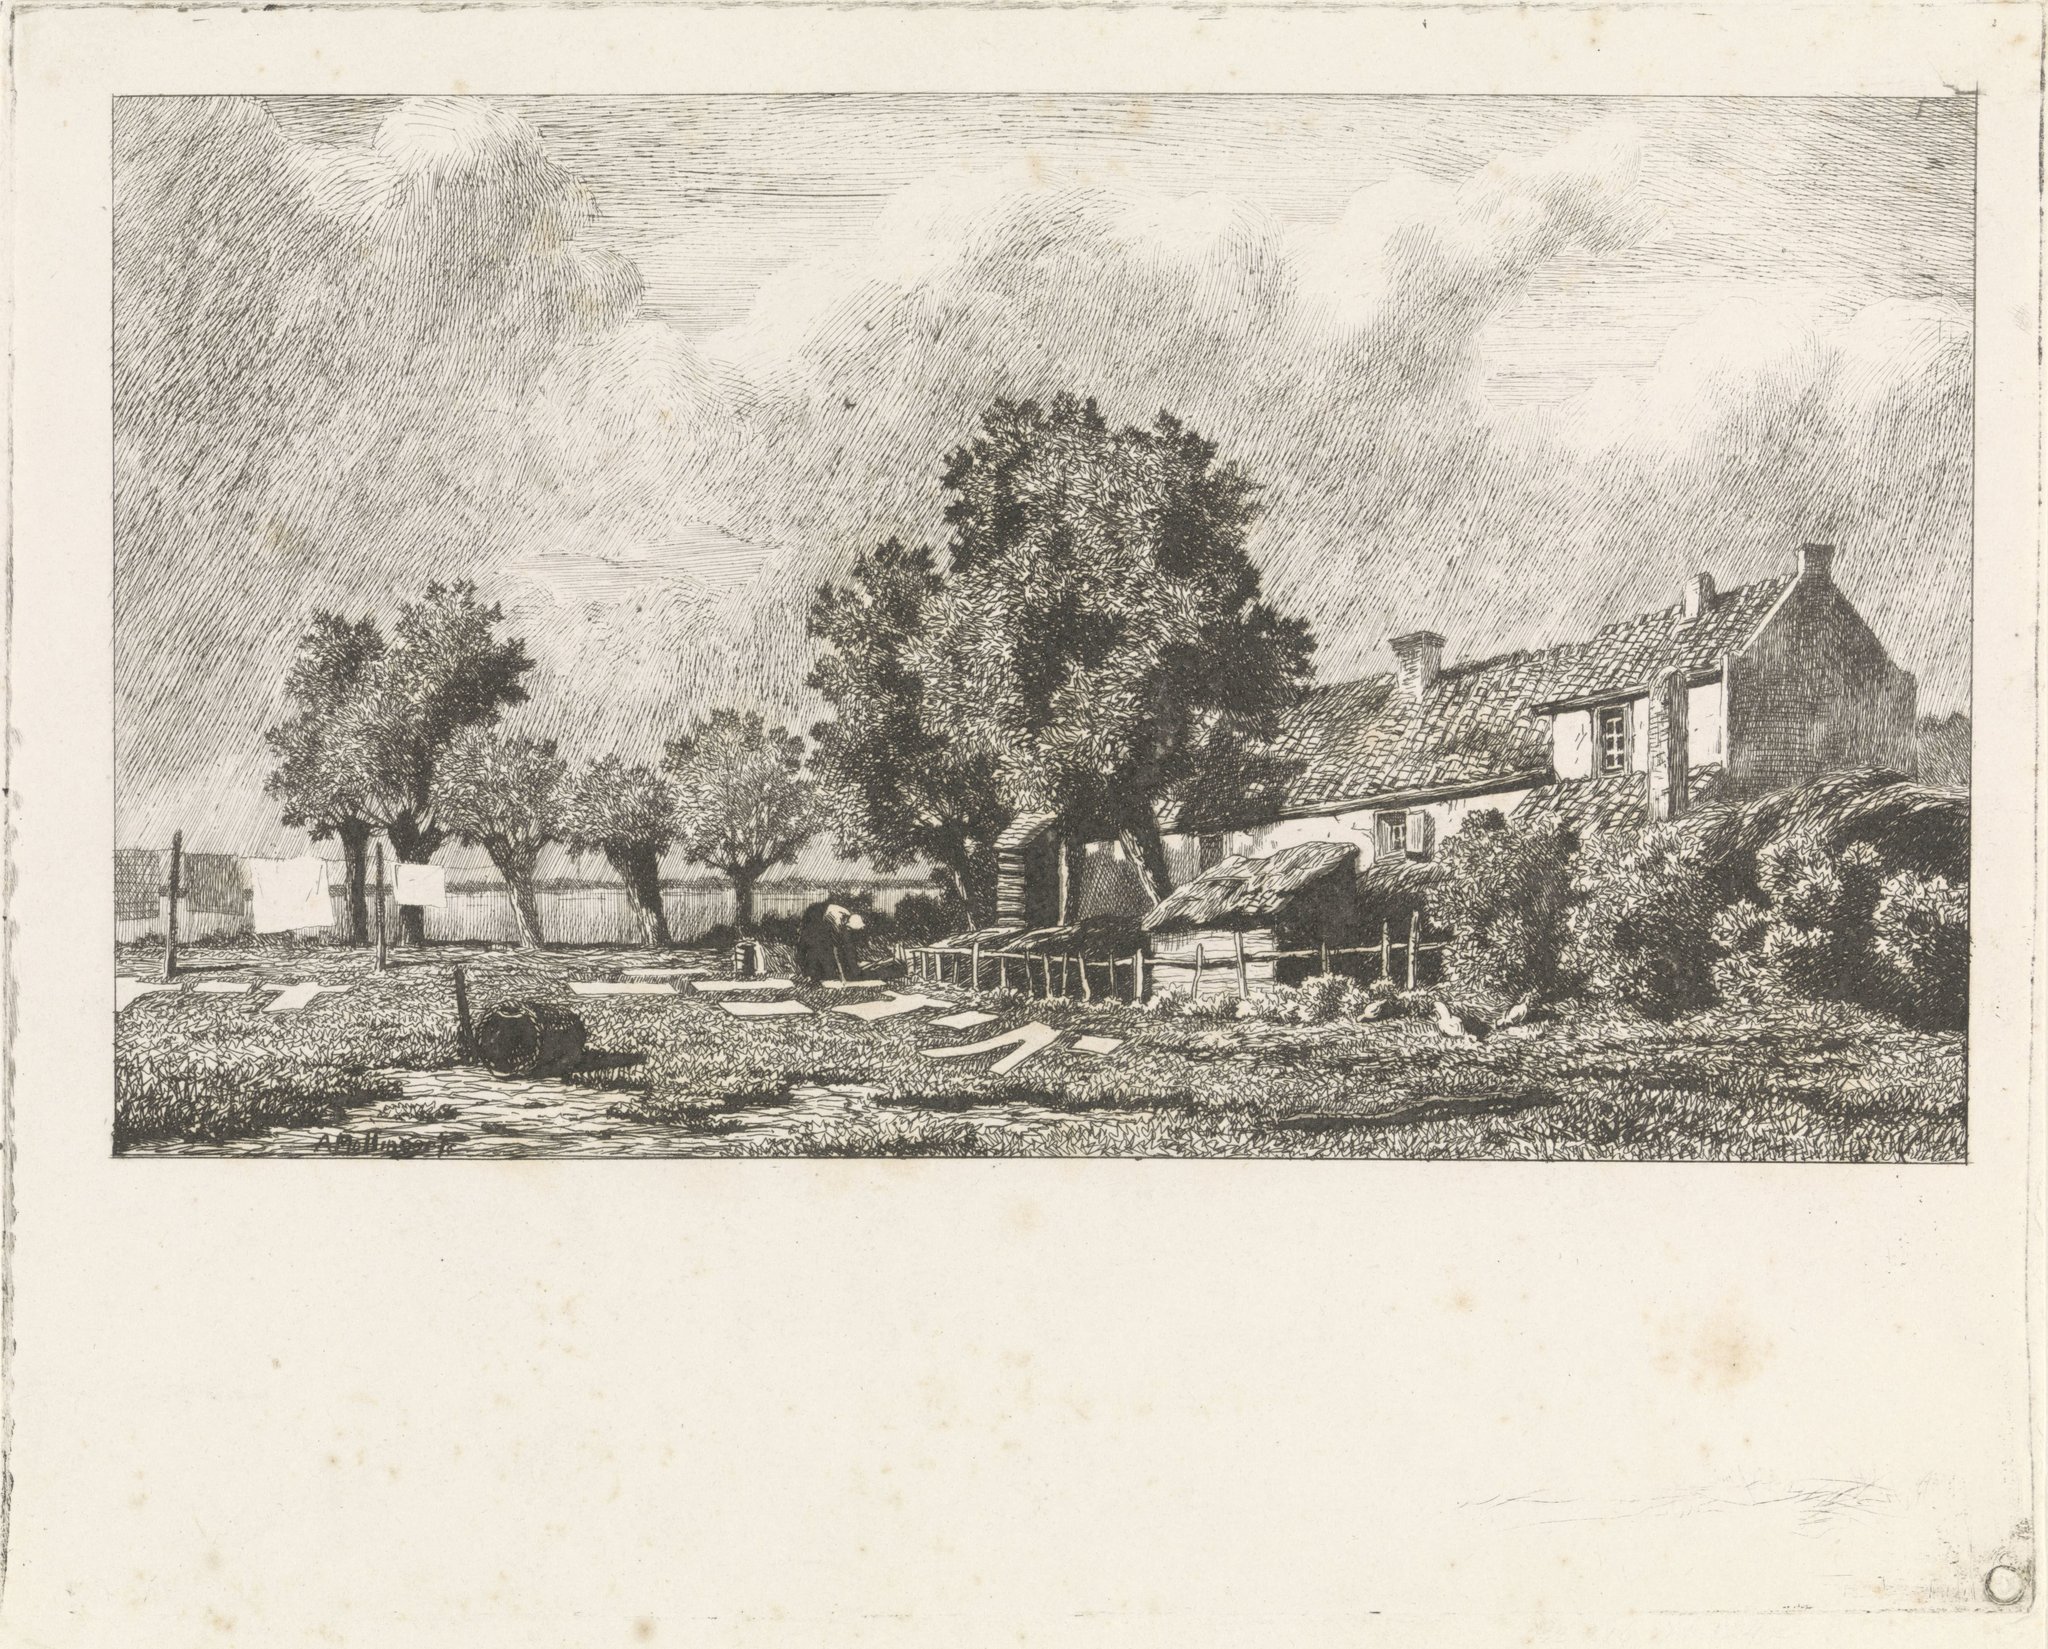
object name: print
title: Bleekveld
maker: alexander mollinger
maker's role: painter, print maker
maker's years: 1836-1867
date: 1846-1867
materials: paper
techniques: etching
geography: netherlands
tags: bleaching (laundering), hanging the wash to dry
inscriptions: collector's mark: Lugt 2228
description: Op een bleekveld legt een vrouw wasgoed op het gras. Links was aan een waslijn, rechts huizen.